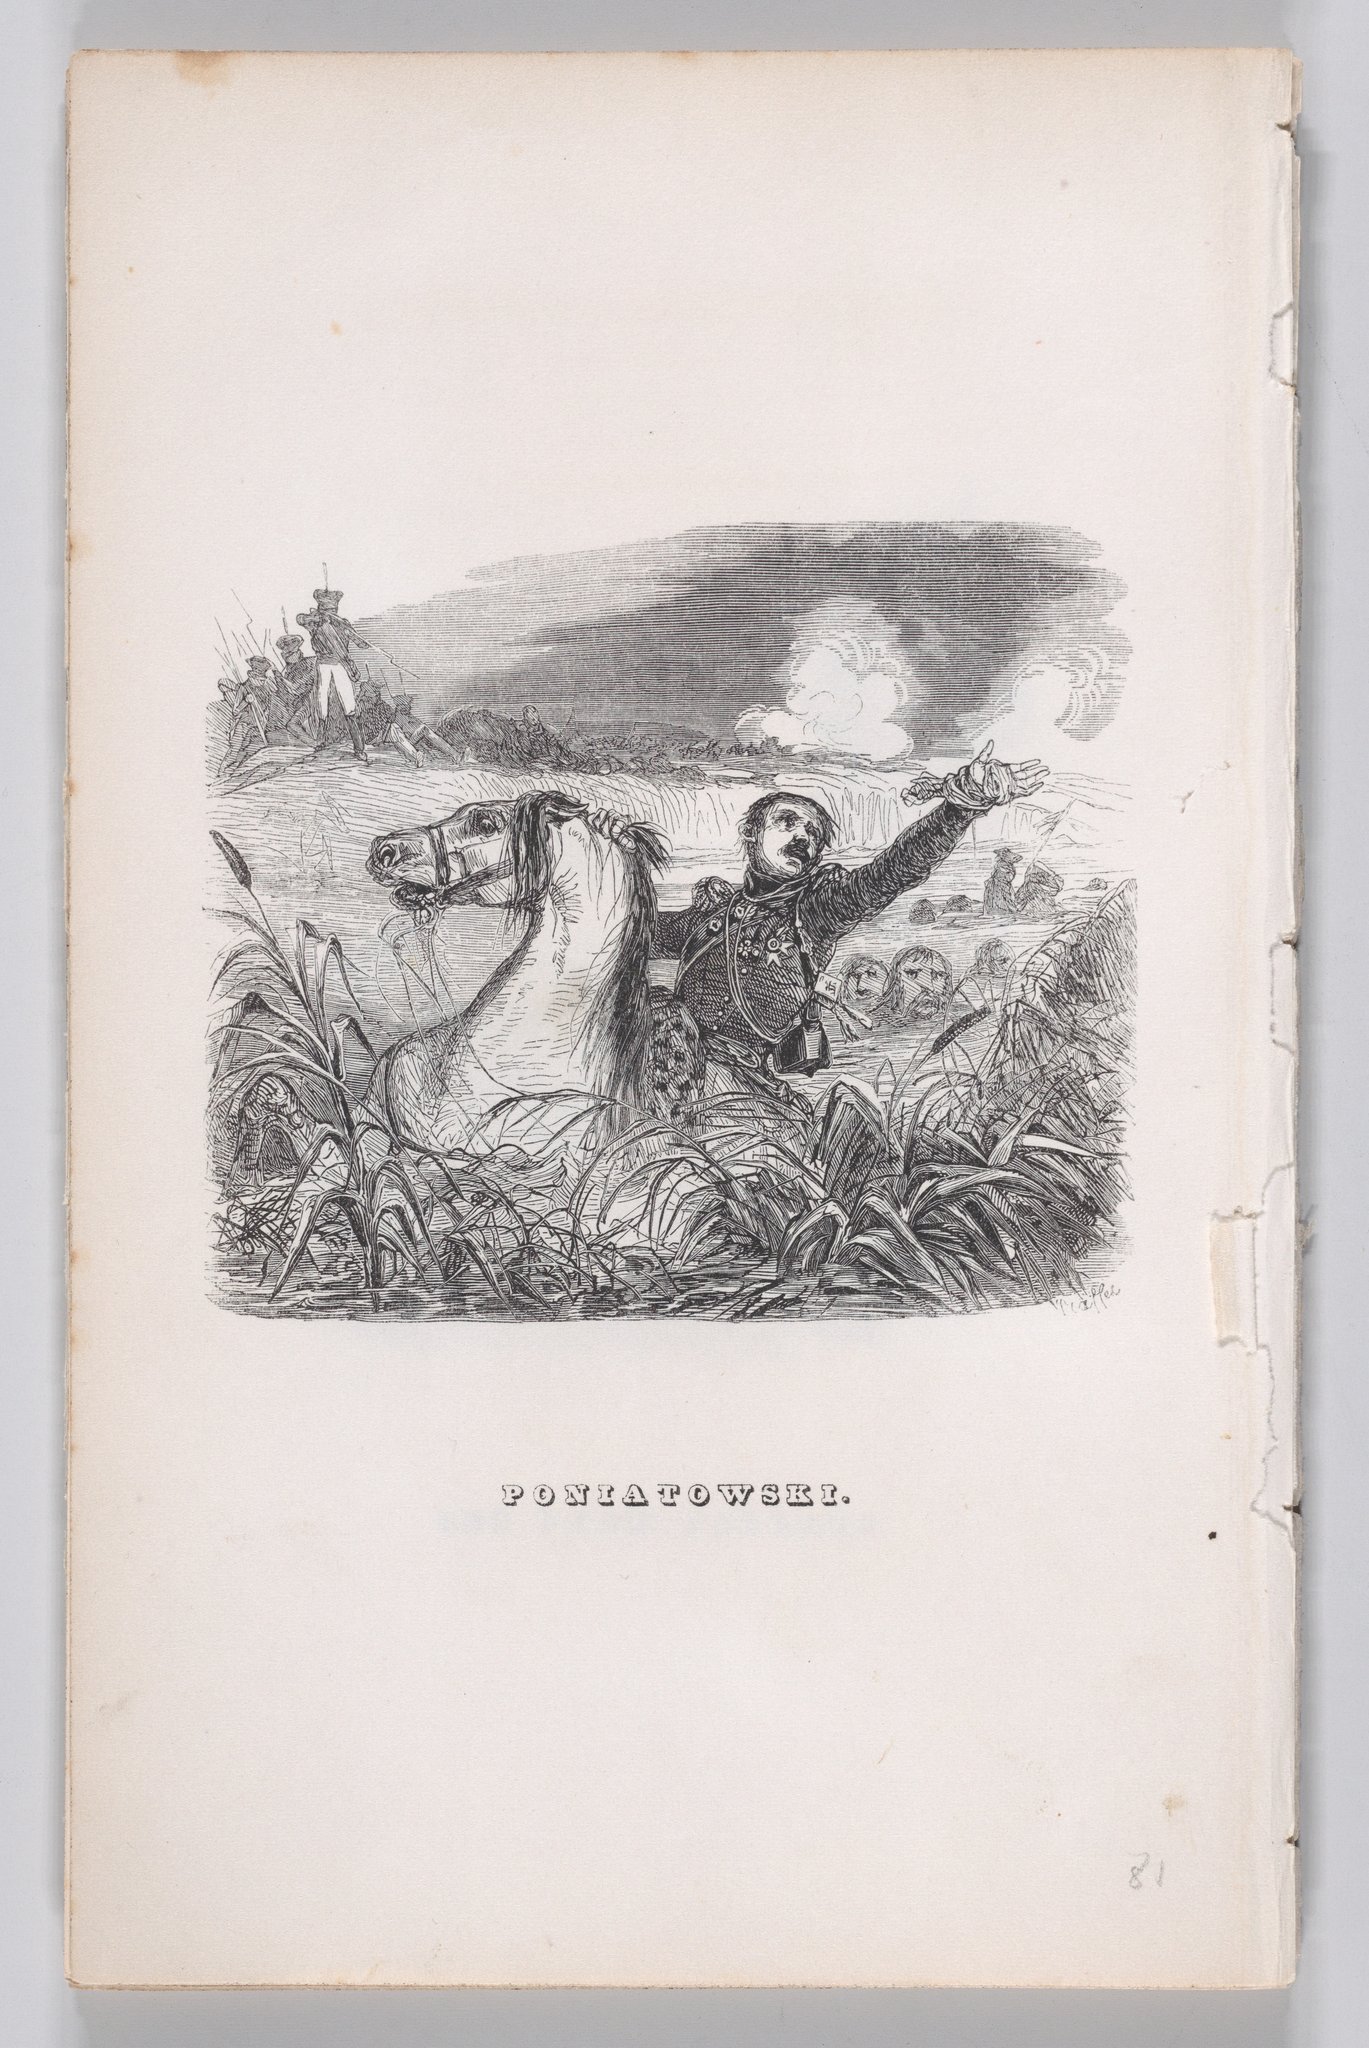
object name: print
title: Poniatowski, from "The Complete Works of Béranger"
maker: j. j. grandville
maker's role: illustrator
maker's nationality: french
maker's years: 1803-1847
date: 1836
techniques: engraving